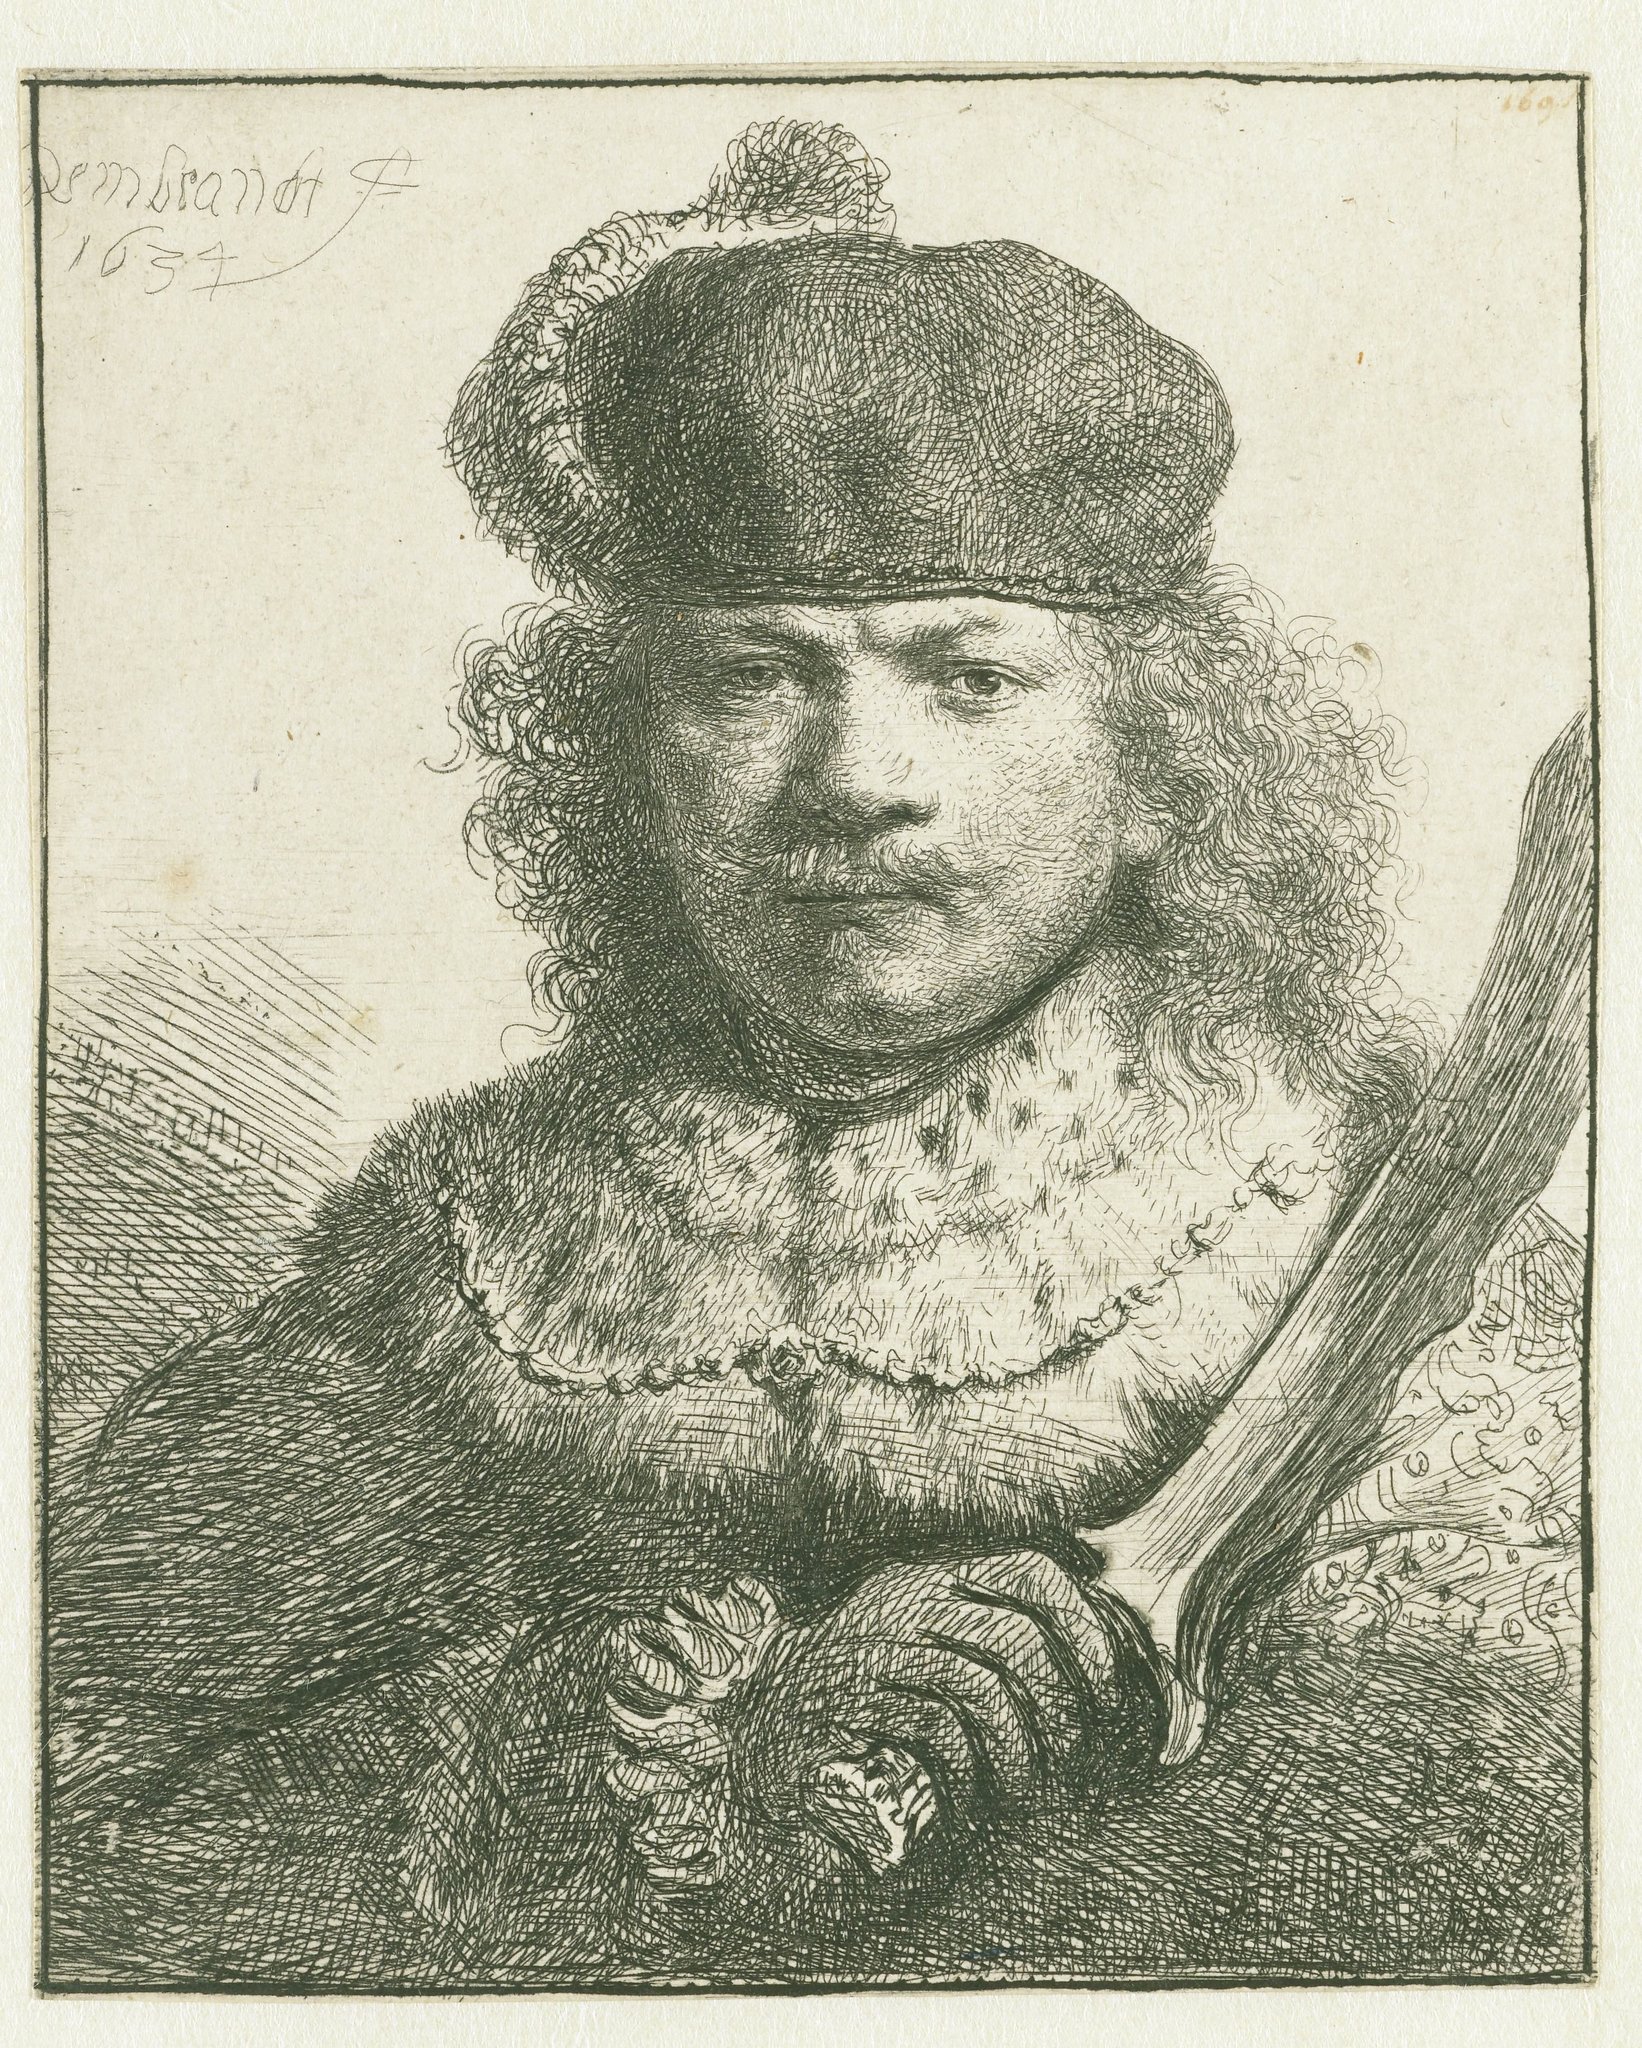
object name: print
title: Self-portrait with raised sabre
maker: rembrandt van rijn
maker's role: draughtsman, painter, print maker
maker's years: 1606-1669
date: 1634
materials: paper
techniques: etching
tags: leiden, amsterdam, painter, print maker, draughtsman, rembrandt van rijn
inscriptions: signature and date: ‘rembrandt f. 1634’, collector's mark: Lugt 2165